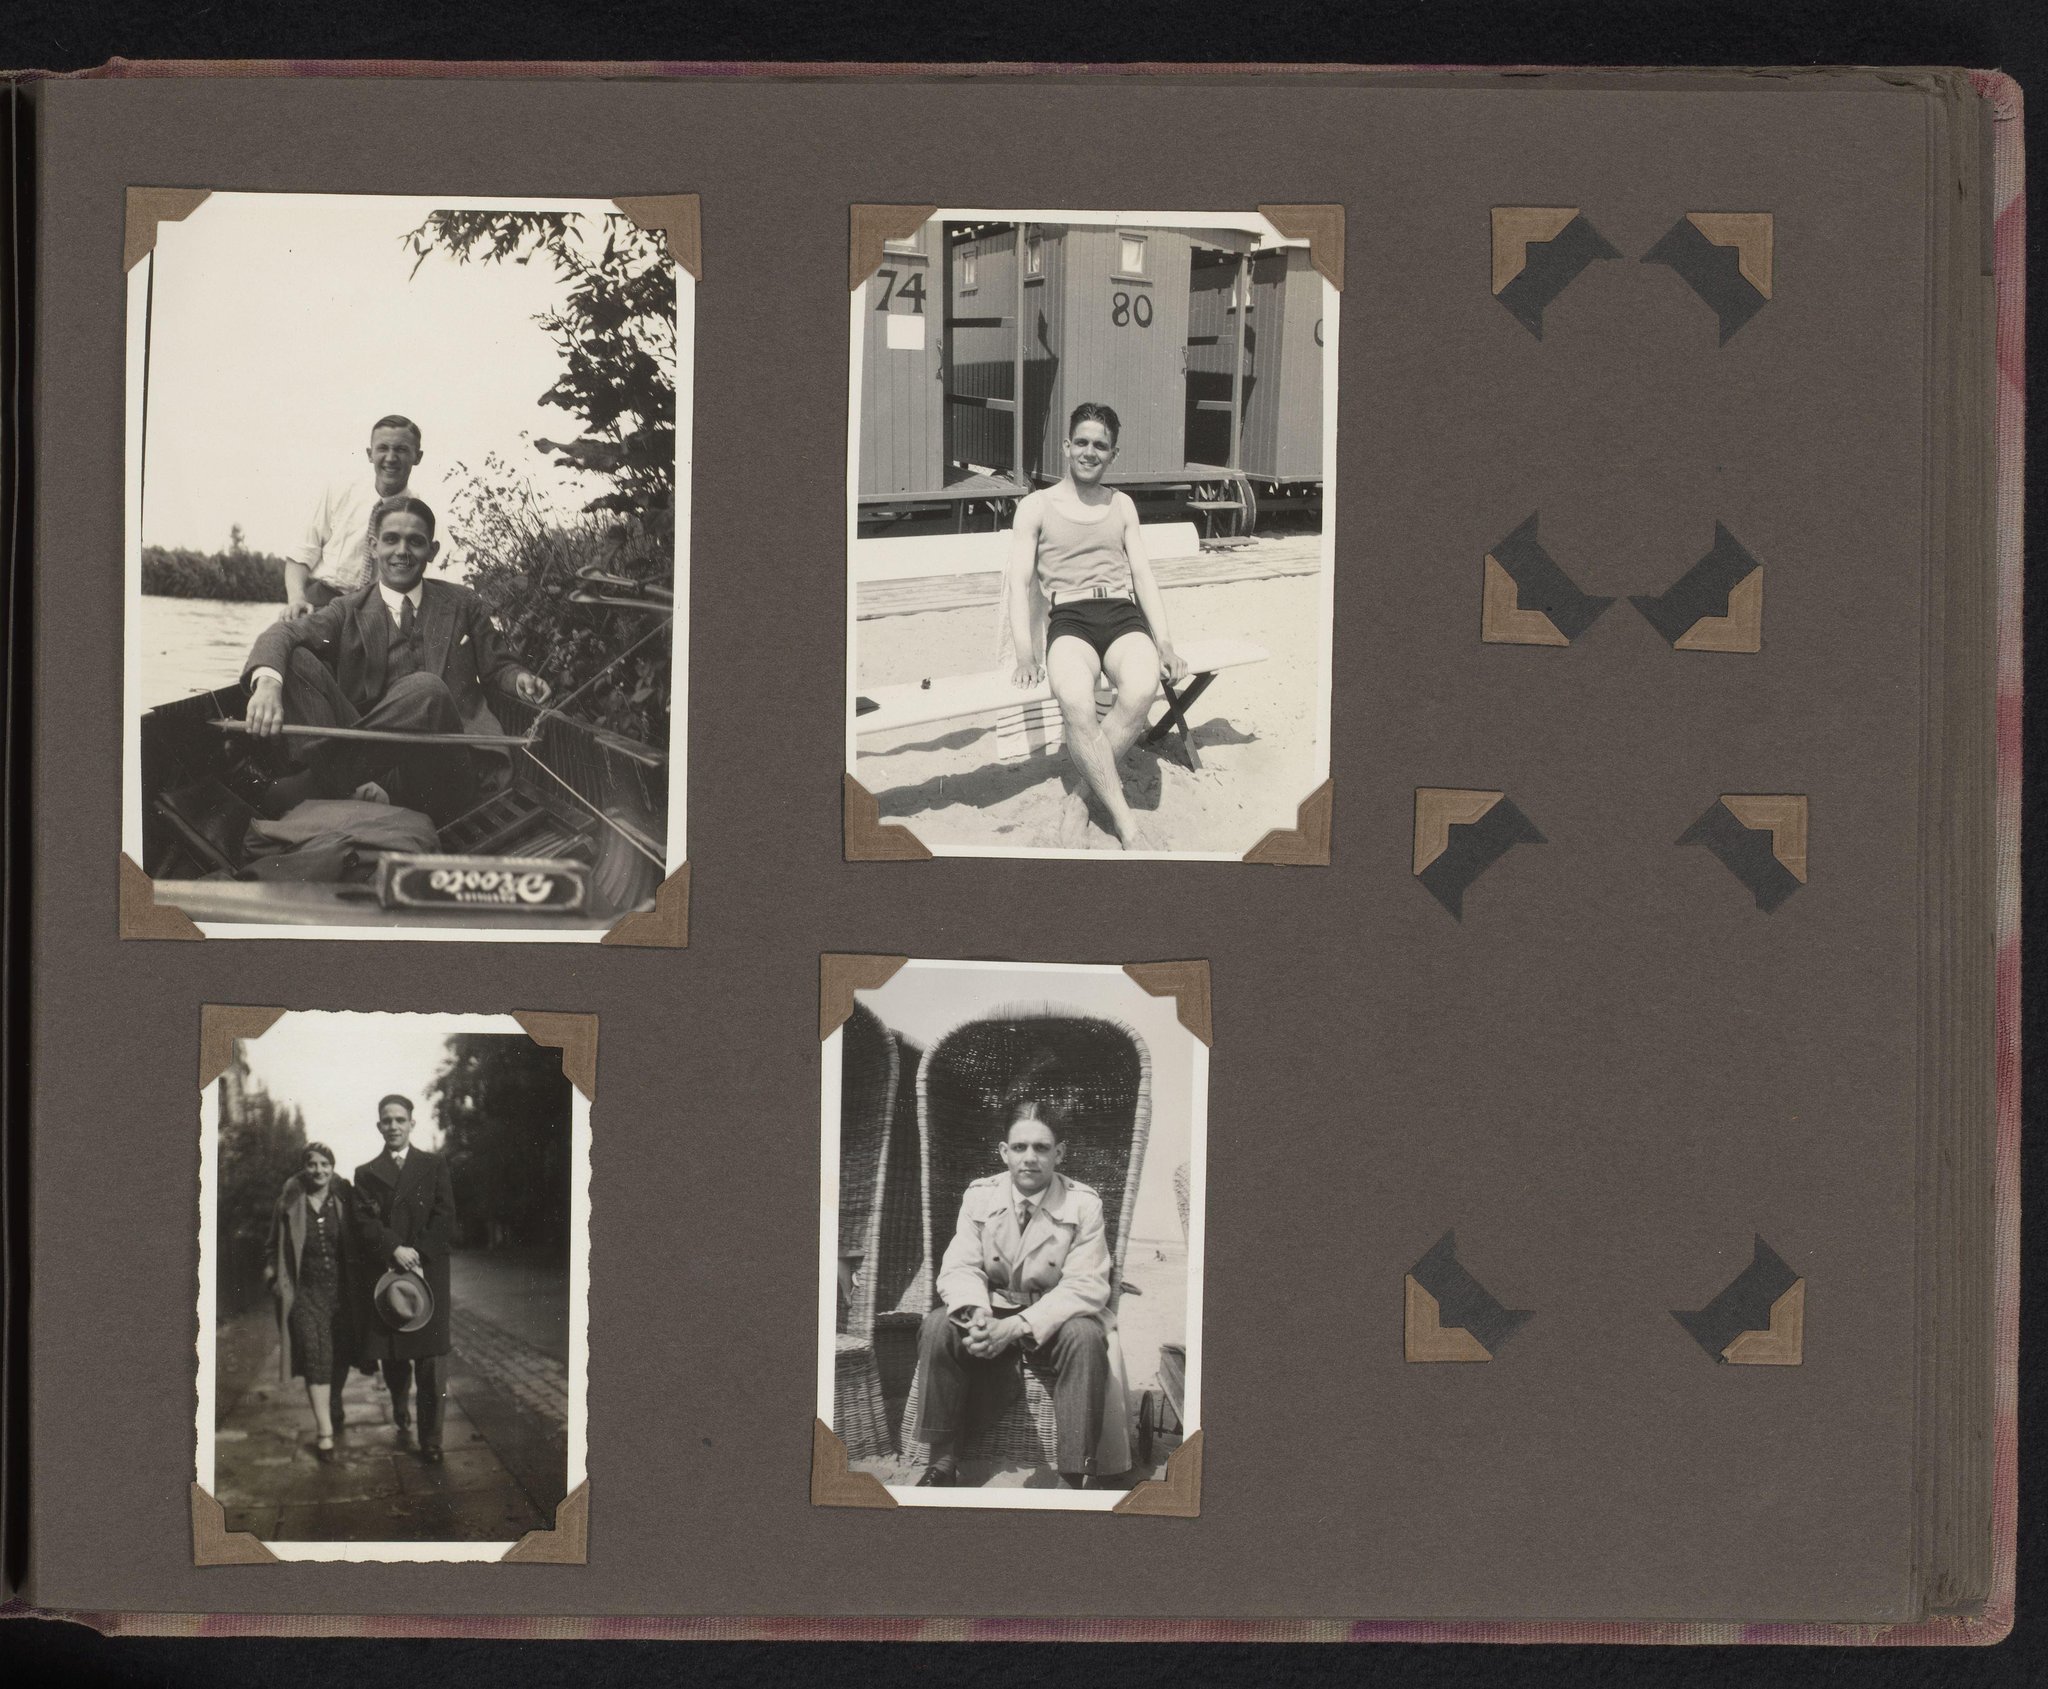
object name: photograph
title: Vier portretten van een kennis van Herman Besselaar en Berti Hoppe, waarvan twee met andere personen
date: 1930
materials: cardboard, photographic support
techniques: gelatin silver print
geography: netherlands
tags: historical persons, rowing-boat, canoe, etc., beach, netherlands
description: De man is afgebeeld in een boot samen met een andere man, op een bank op het strand, samen met een vrouw en in een strandstoel. Deze foto's maken deel uit van een album.